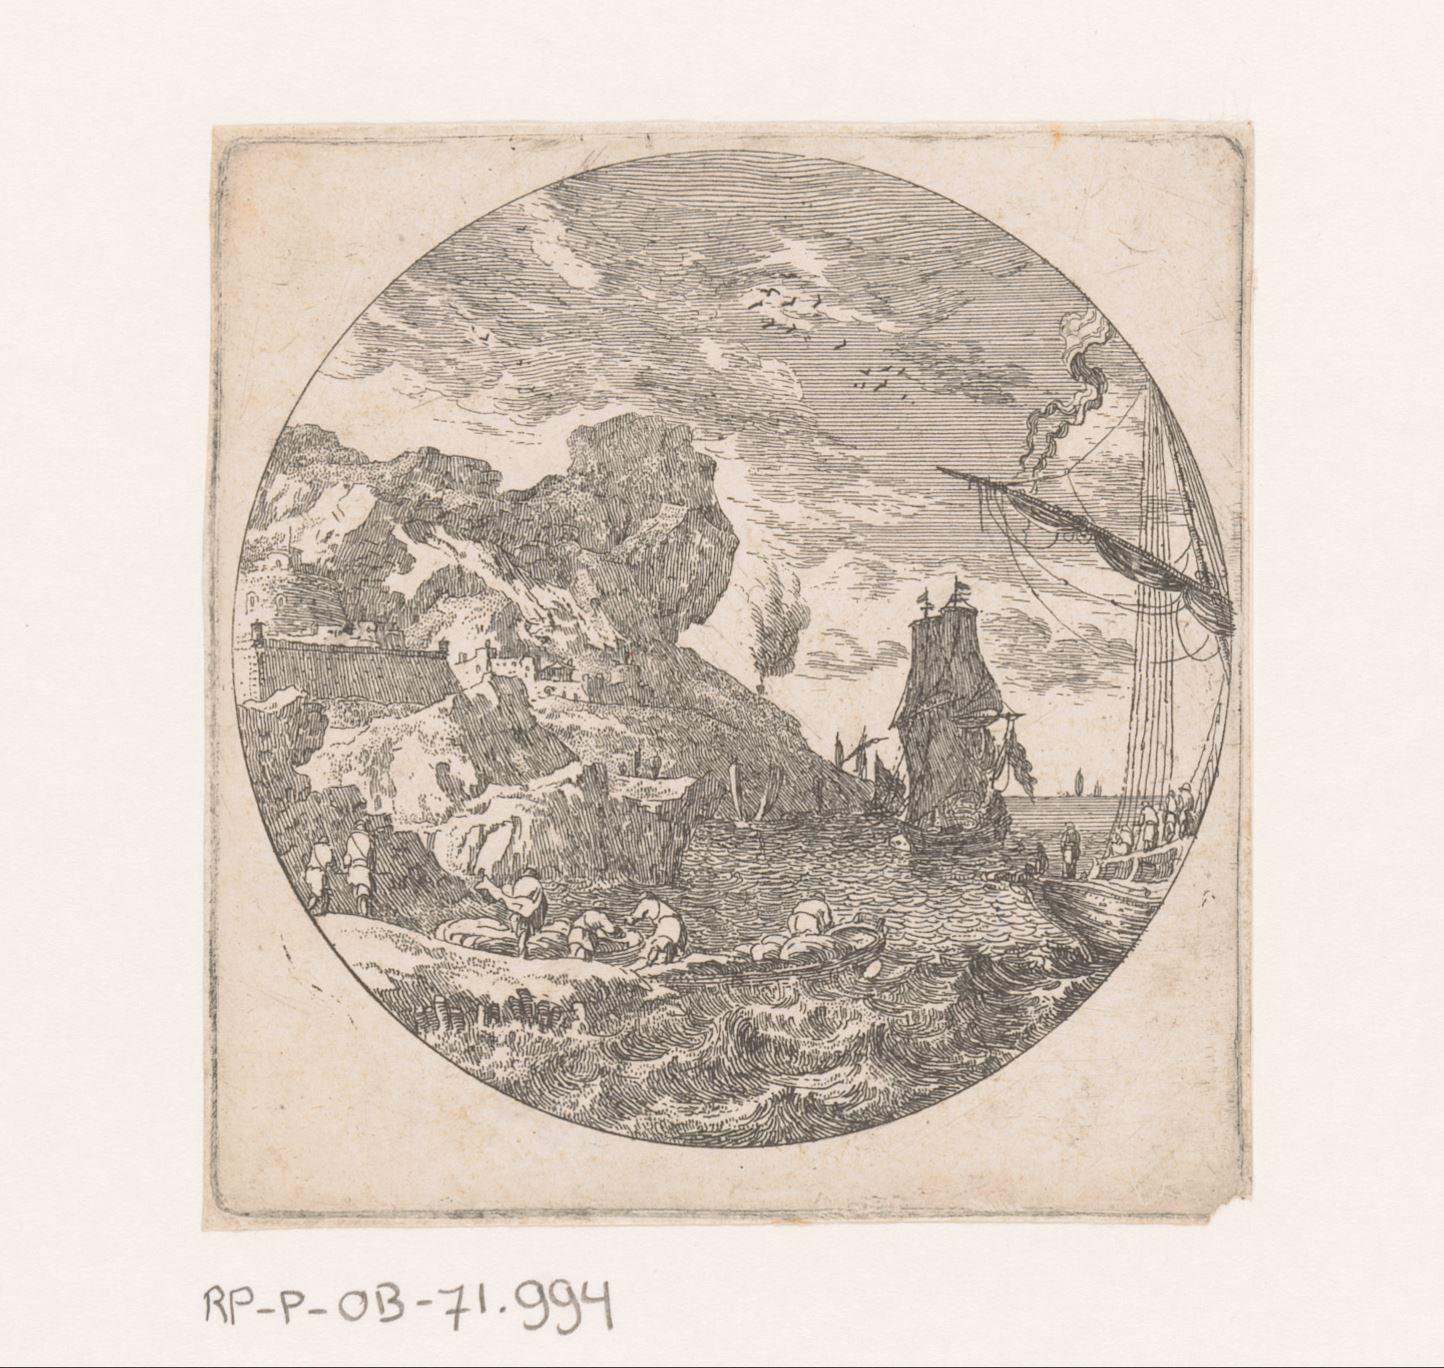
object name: print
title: Kustgezicht met schepen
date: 1613-1695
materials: paper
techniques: etching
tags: coast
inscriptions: collector's mark: Lugt 2228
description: Prenten met het signatuur 'Perelle' kunnen zowel door vader Gabriel als door zonen Nicolas en Adam gemaakt zijn.